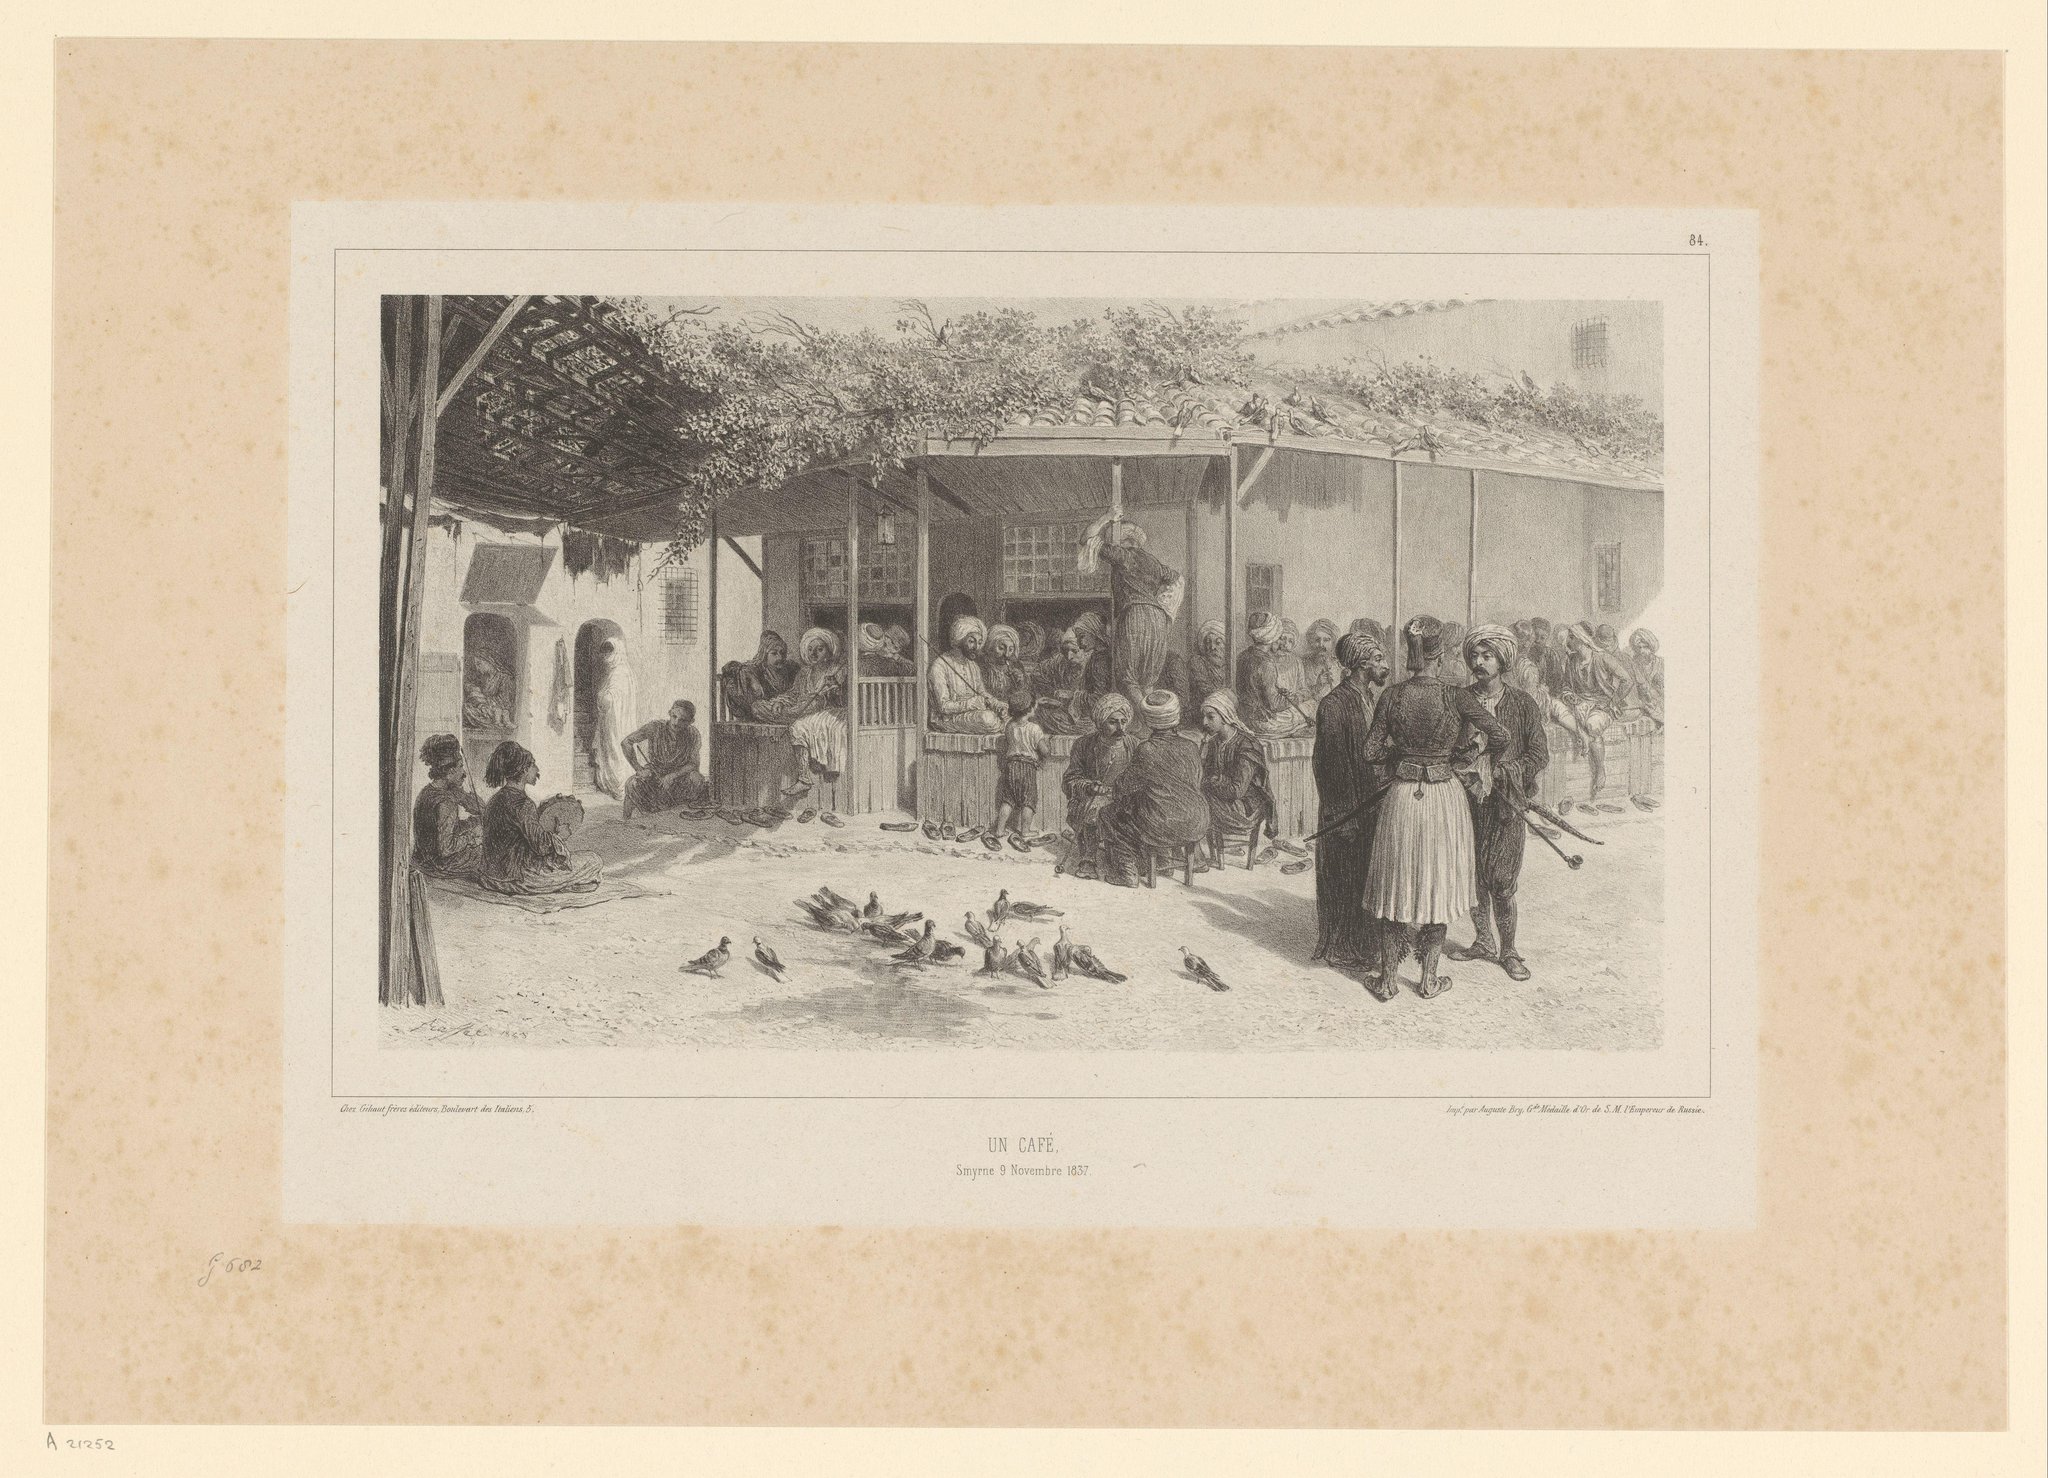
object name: print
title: Mannen zittend op een terras van een café in Izmir, 9 november 1837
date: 1848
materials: paper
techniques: lithograph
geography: paris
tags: pipe ~ tobacco, terrace, restaurant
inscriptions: collector's mark: Lugt 964